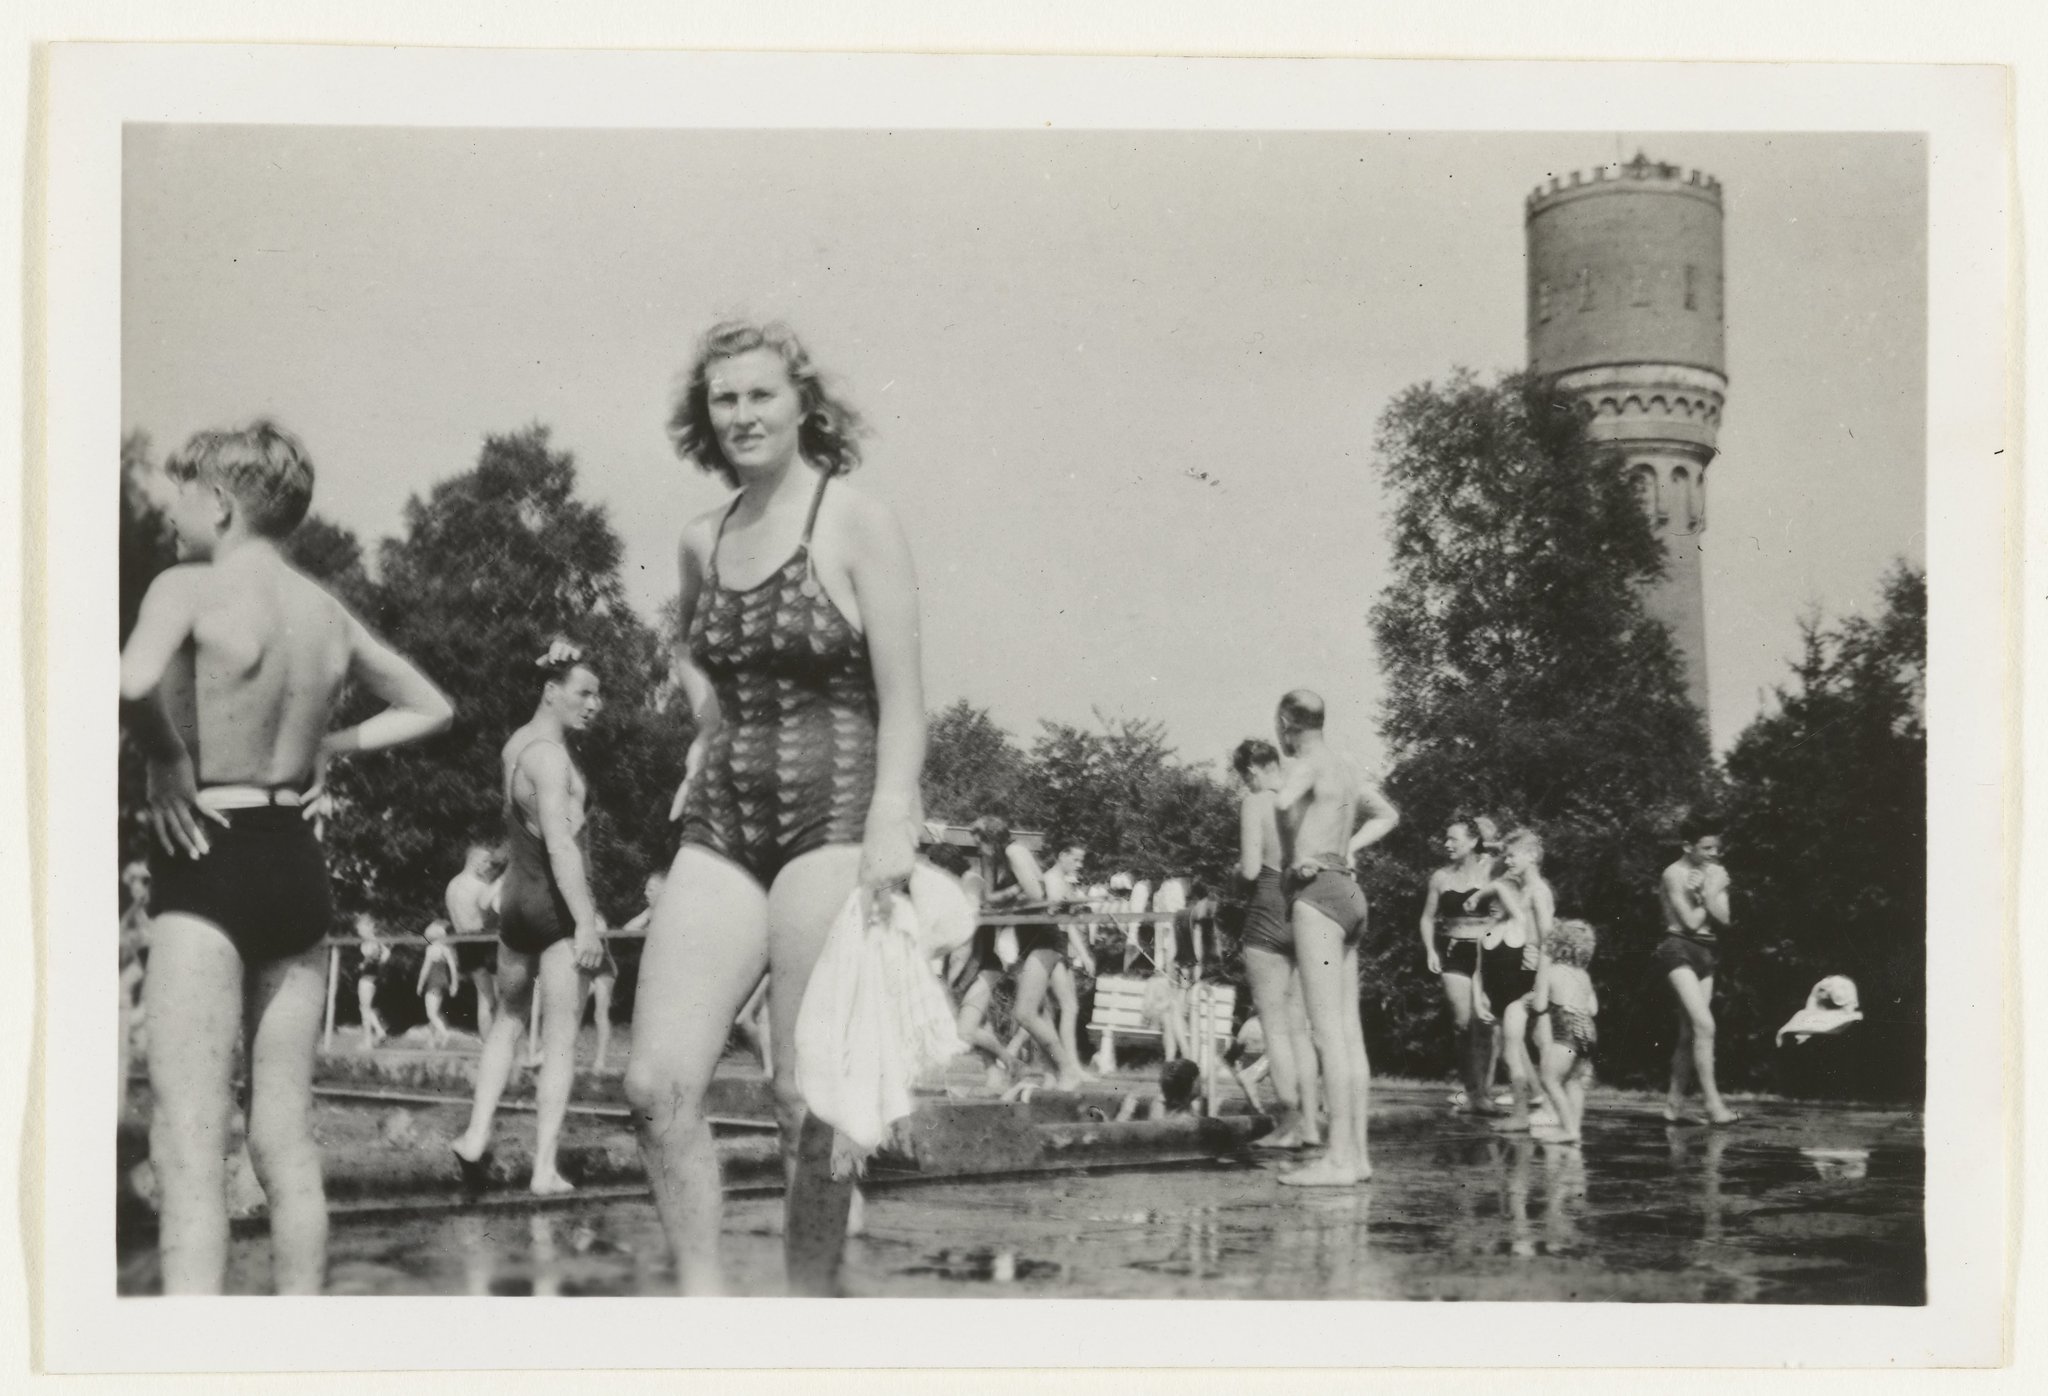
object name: photograph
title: Openlucht zwembad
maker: Anonymous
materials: photographic support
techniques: gelatin silver print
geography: netherlands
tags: occupier and civilians, swimming (sport), recreation ~ the soldier off duty, occupation ~ war, netherlands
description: Een openlucht zwembad met mensen in badpak. Achter hen een watertoren.